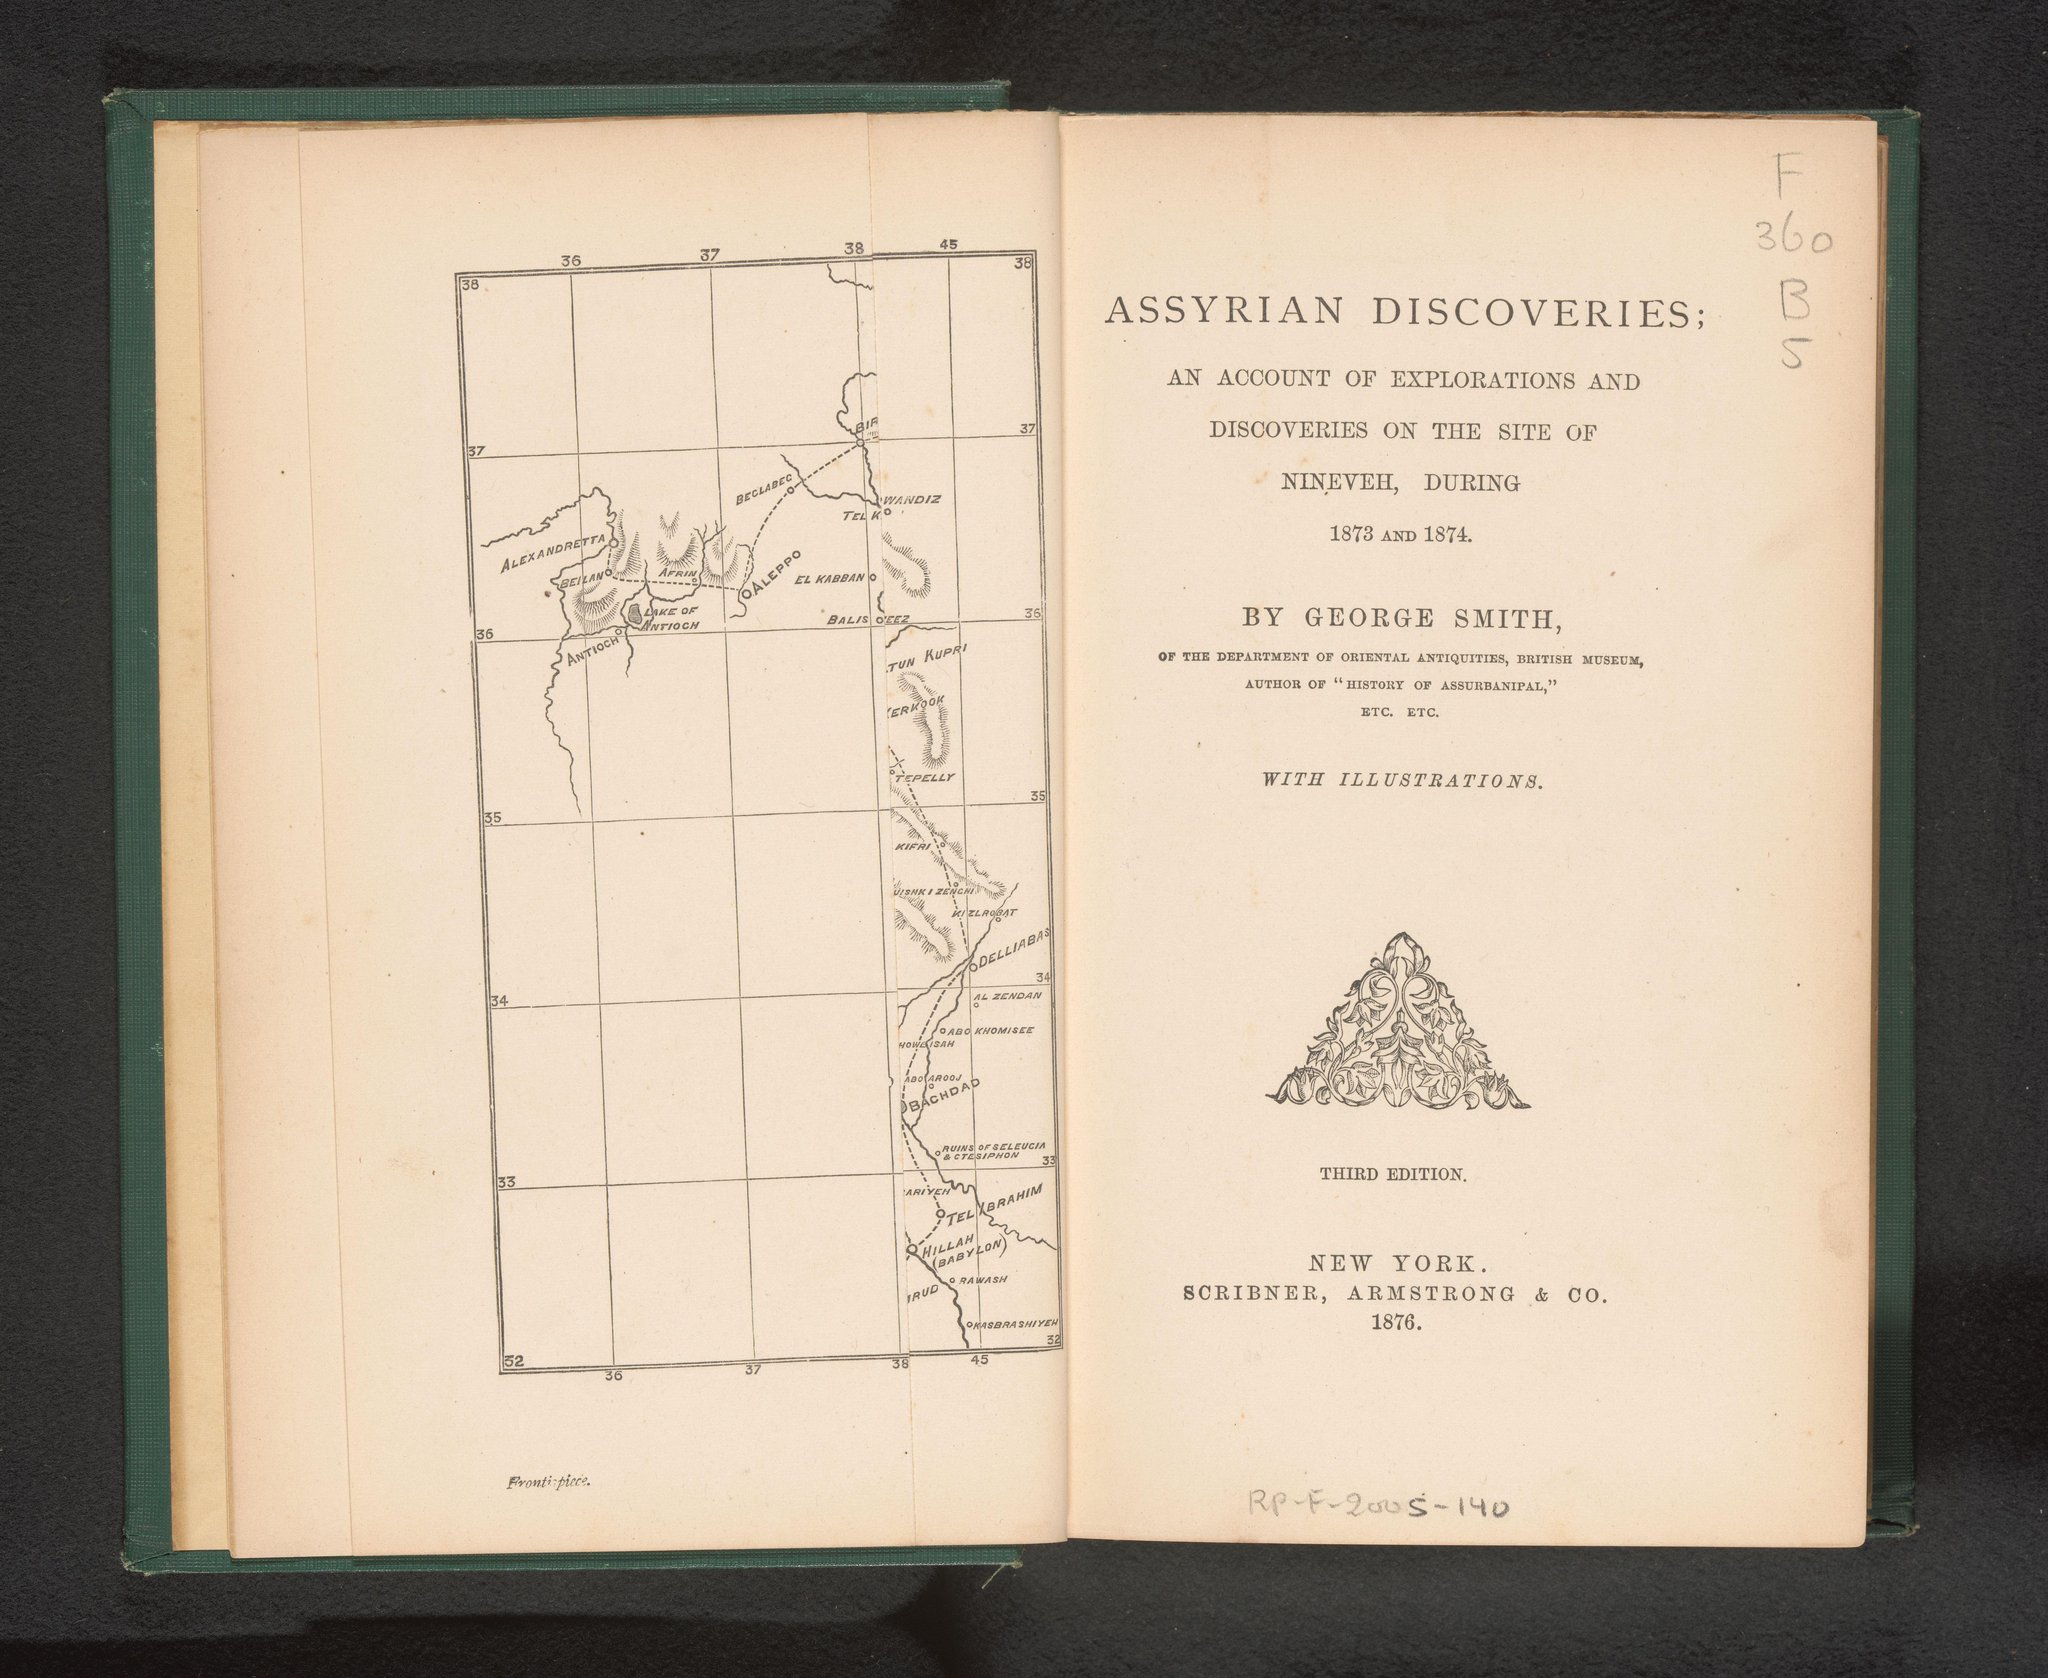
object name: book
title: Assyrian discoveries : an account of explorations and discoveries on the site of Nineveh, during 1873 and 1874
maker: george smith (assyrioloog)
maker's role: archeoloog, historicus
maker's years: 1840-1876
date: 1876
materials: cardboard, paper, textile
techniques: printing, woodburytype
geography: new york city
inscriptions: annotation: ‘Sept/ 2005’, annotation: ‘Dec 25 1885/ S. Hill’, annotation: ‘J. L. Dyer/ from/ Mother Hill’